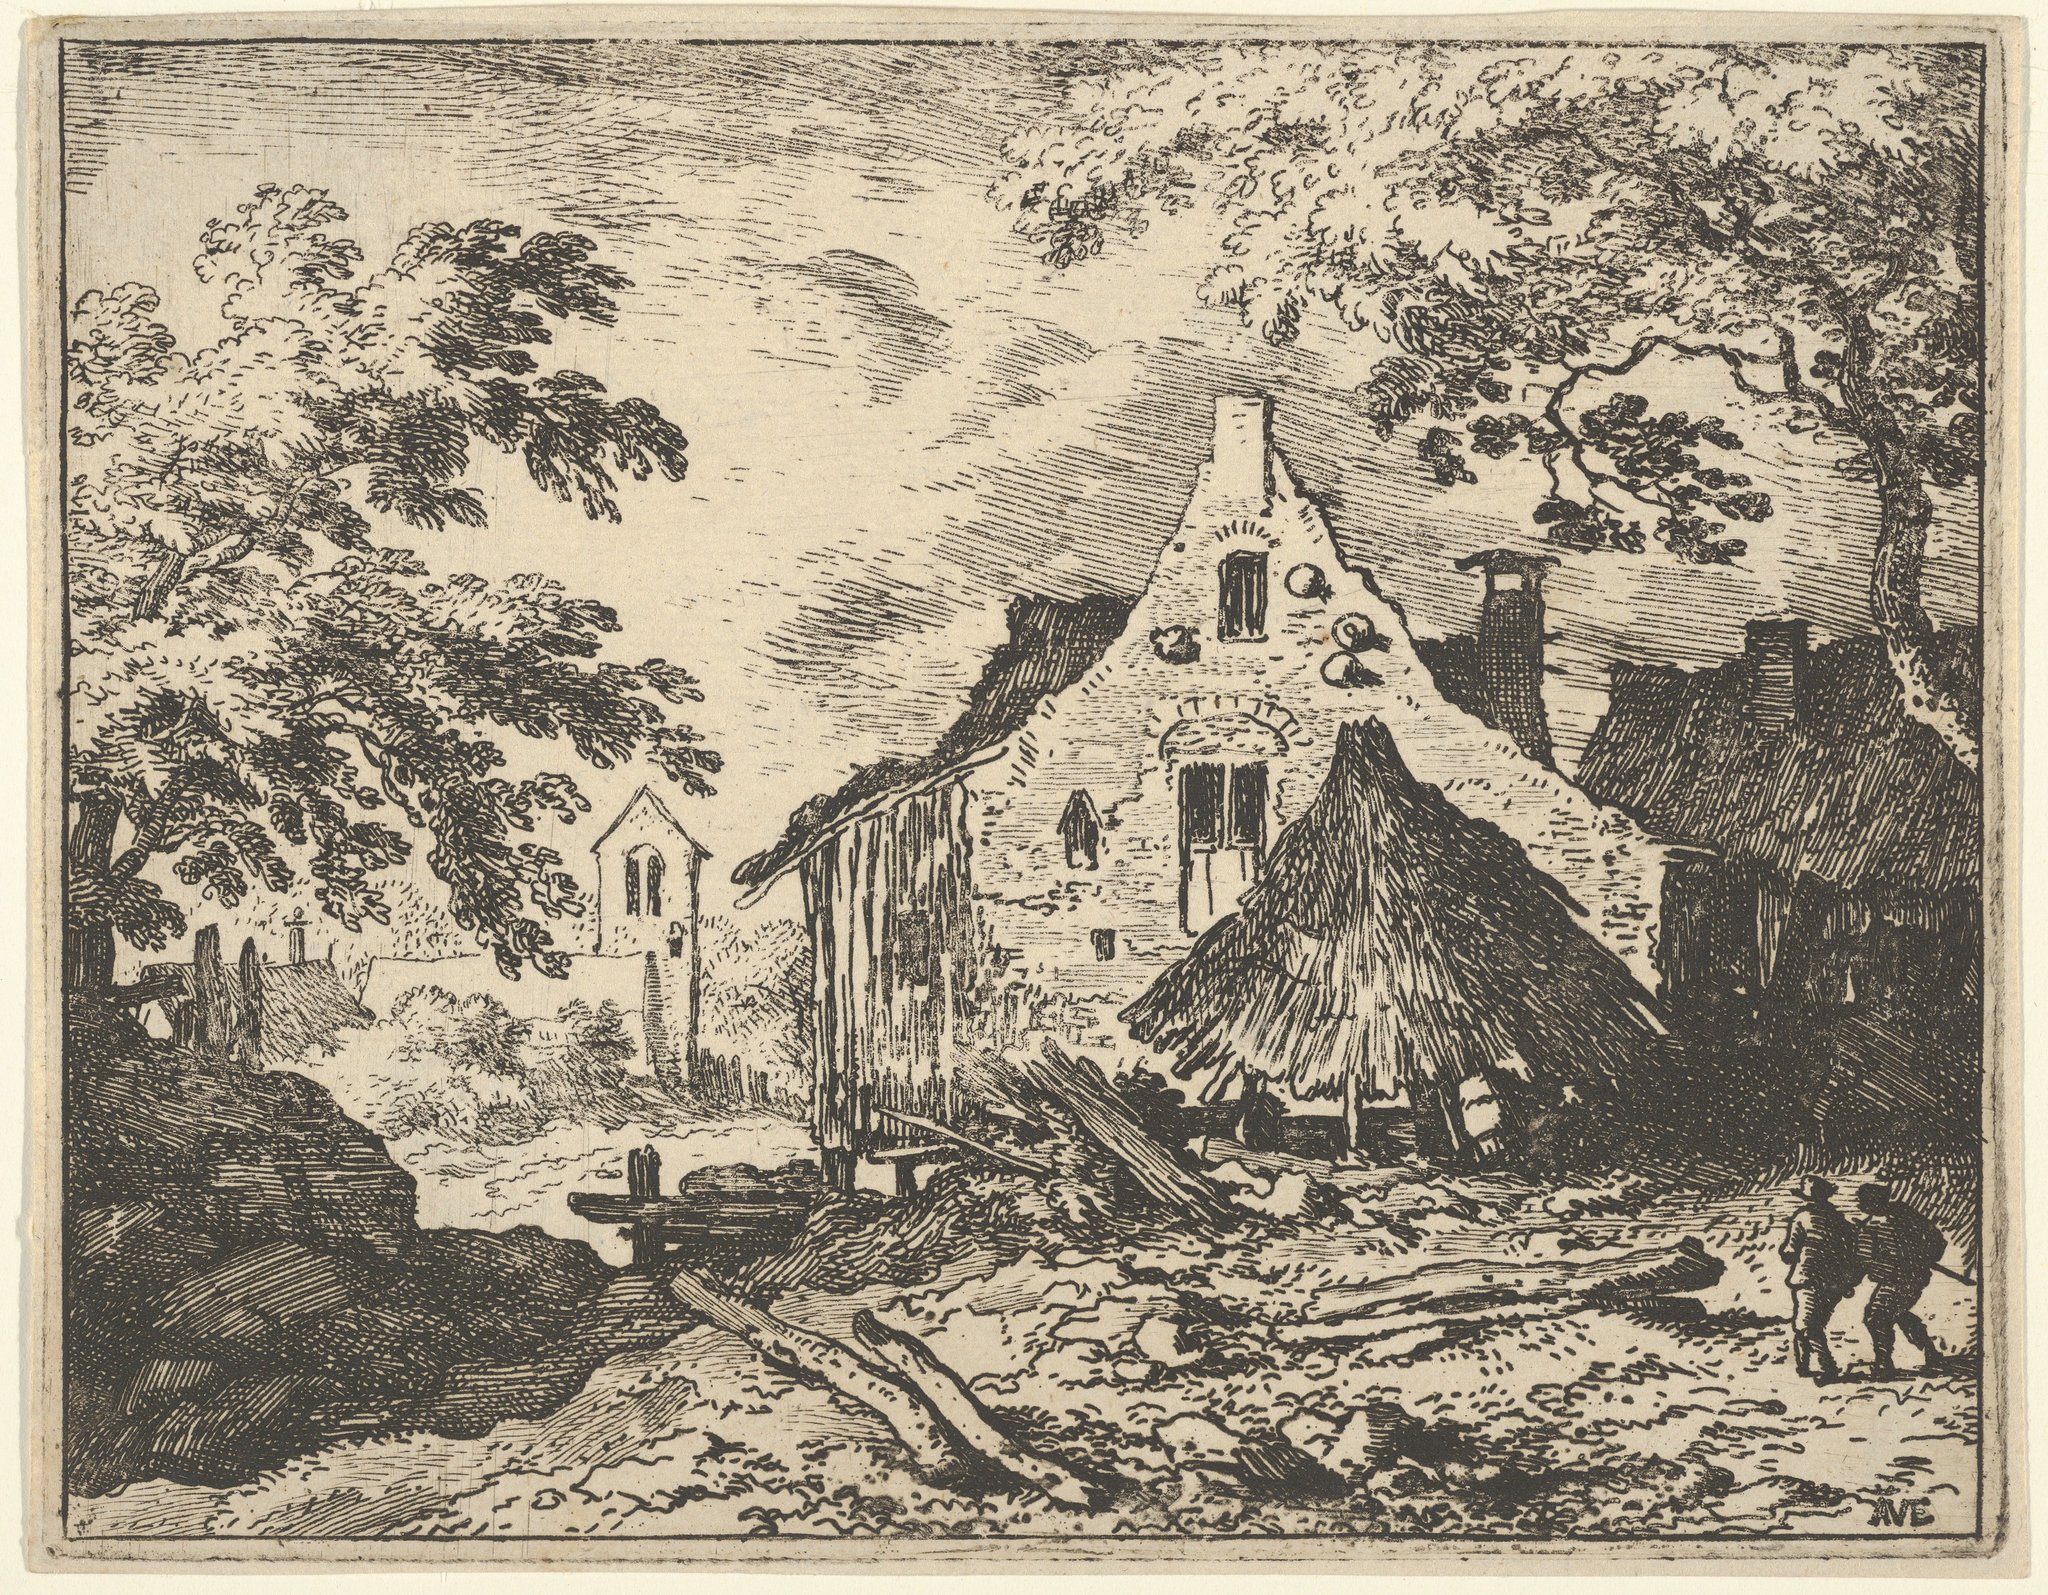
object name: print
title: The Haybarn with Movable Roof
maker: allart van everdingen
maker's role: artist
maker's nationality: dutch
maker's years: 1621-1675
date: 1621-1675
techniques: engraving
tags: barns